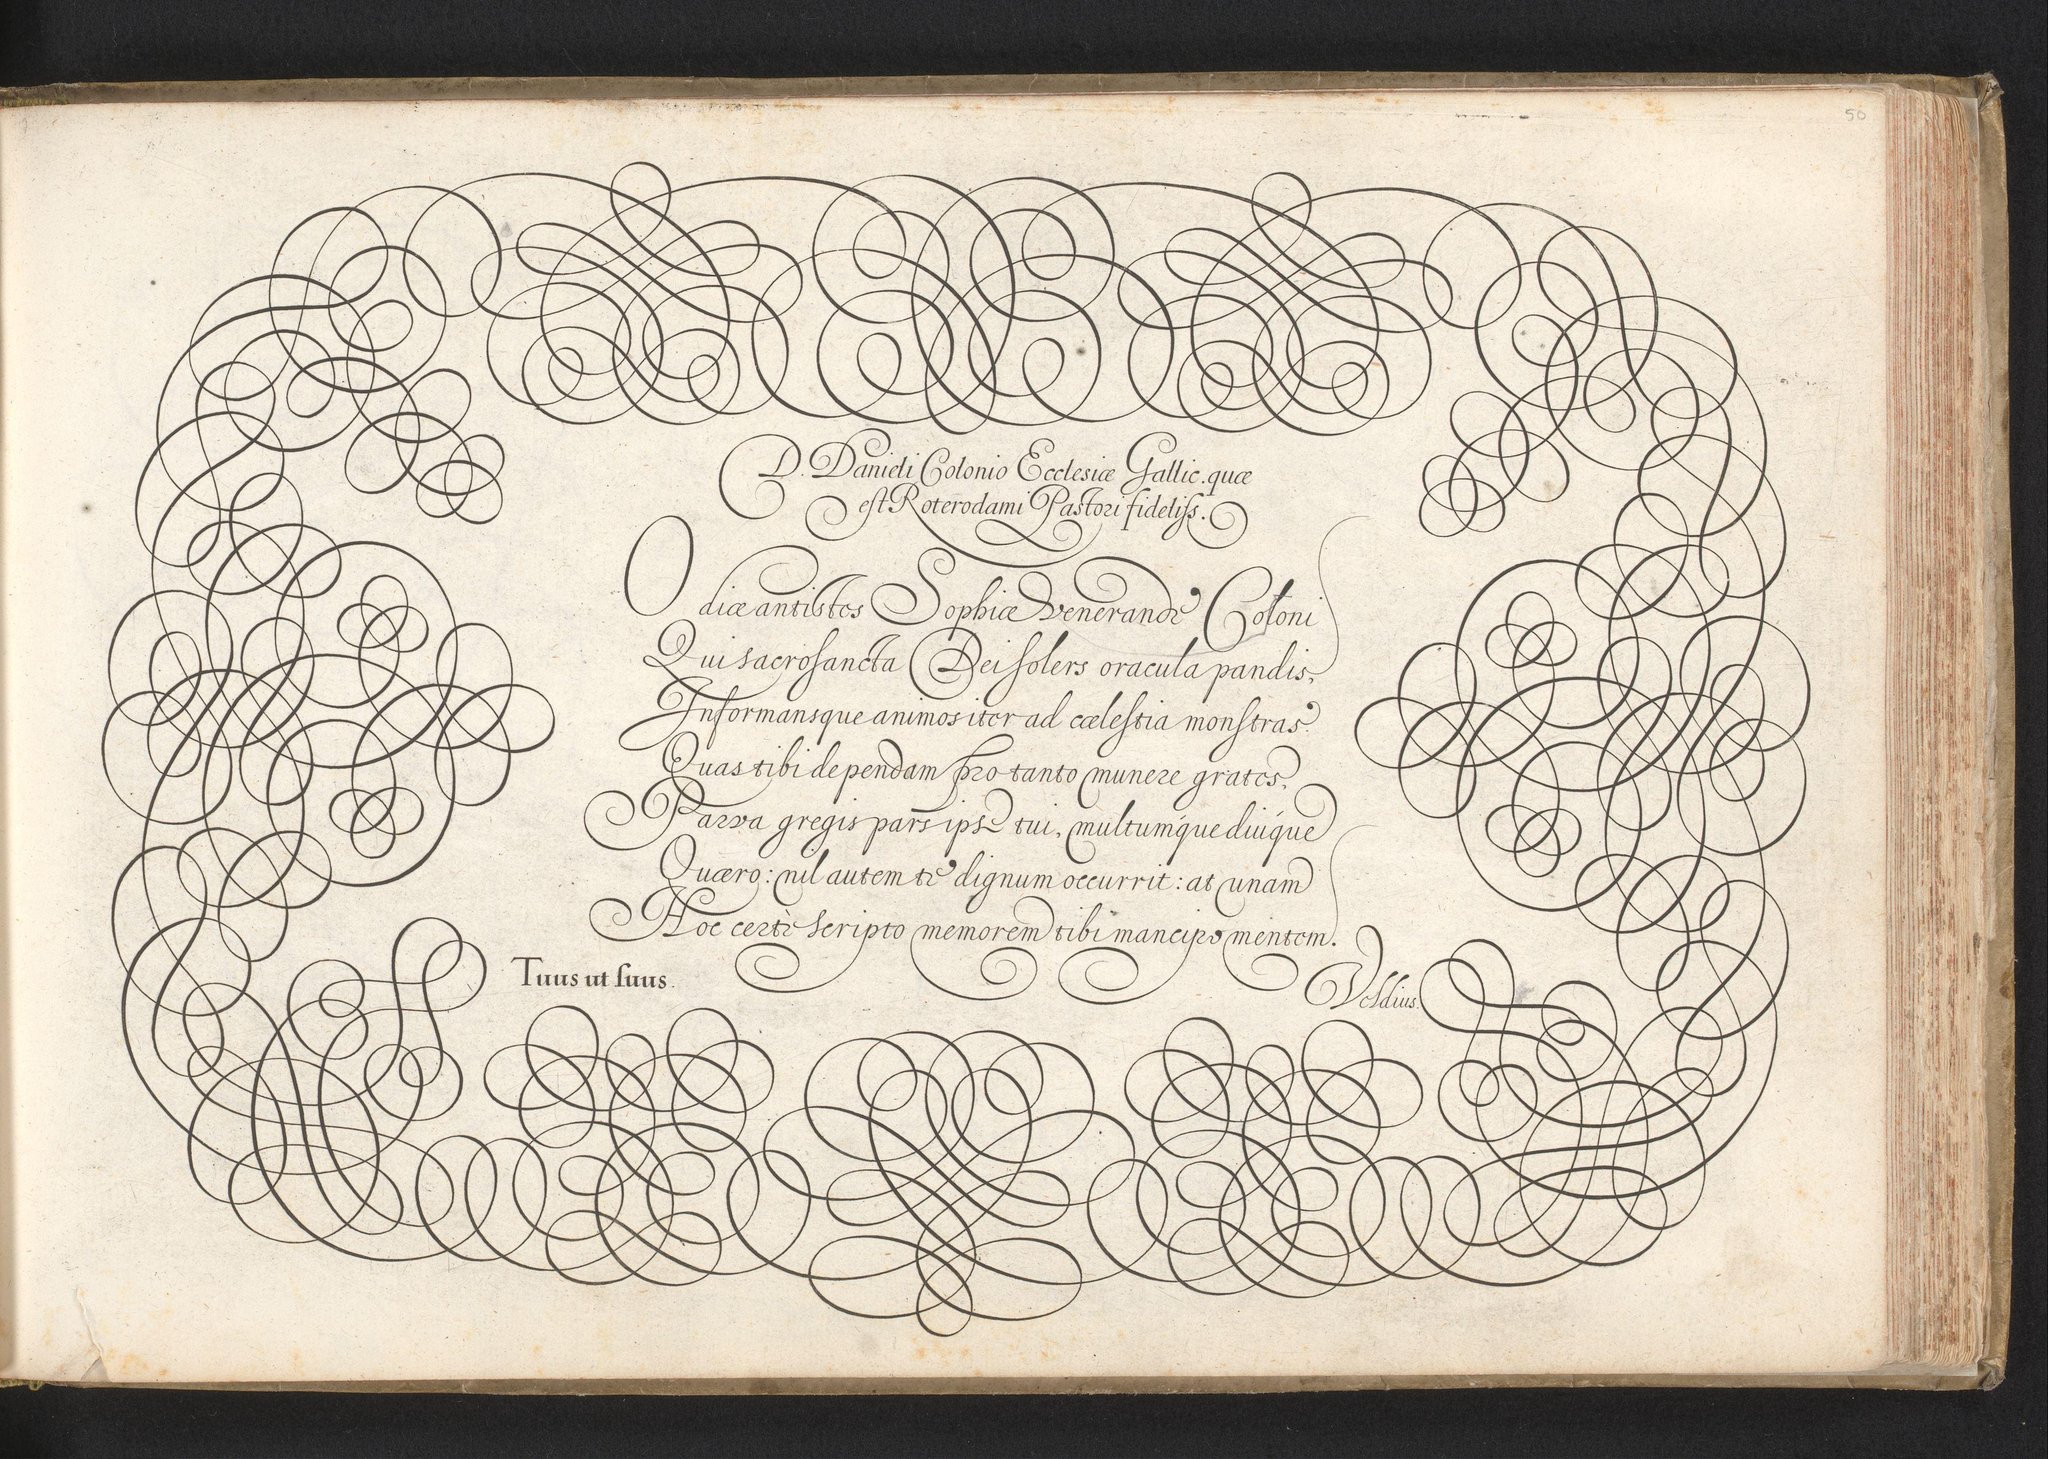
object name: ornament print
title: Thrésor litéraire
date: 1605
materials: paper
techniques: engraving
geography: haarlem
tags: calligraphy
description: Schrijfvoorbeeld met de aanhef: D. Daniels Colonio ecclesiae Gallie quae est Roterodami pastori fideliss. Daaronder zeven regels tekst in het Latijn: O diae antistes ... Ondertekend: Tuus ut suus Veldius. De tekst is omlijst door krulwerk. De prent maakt deel uit van een album.